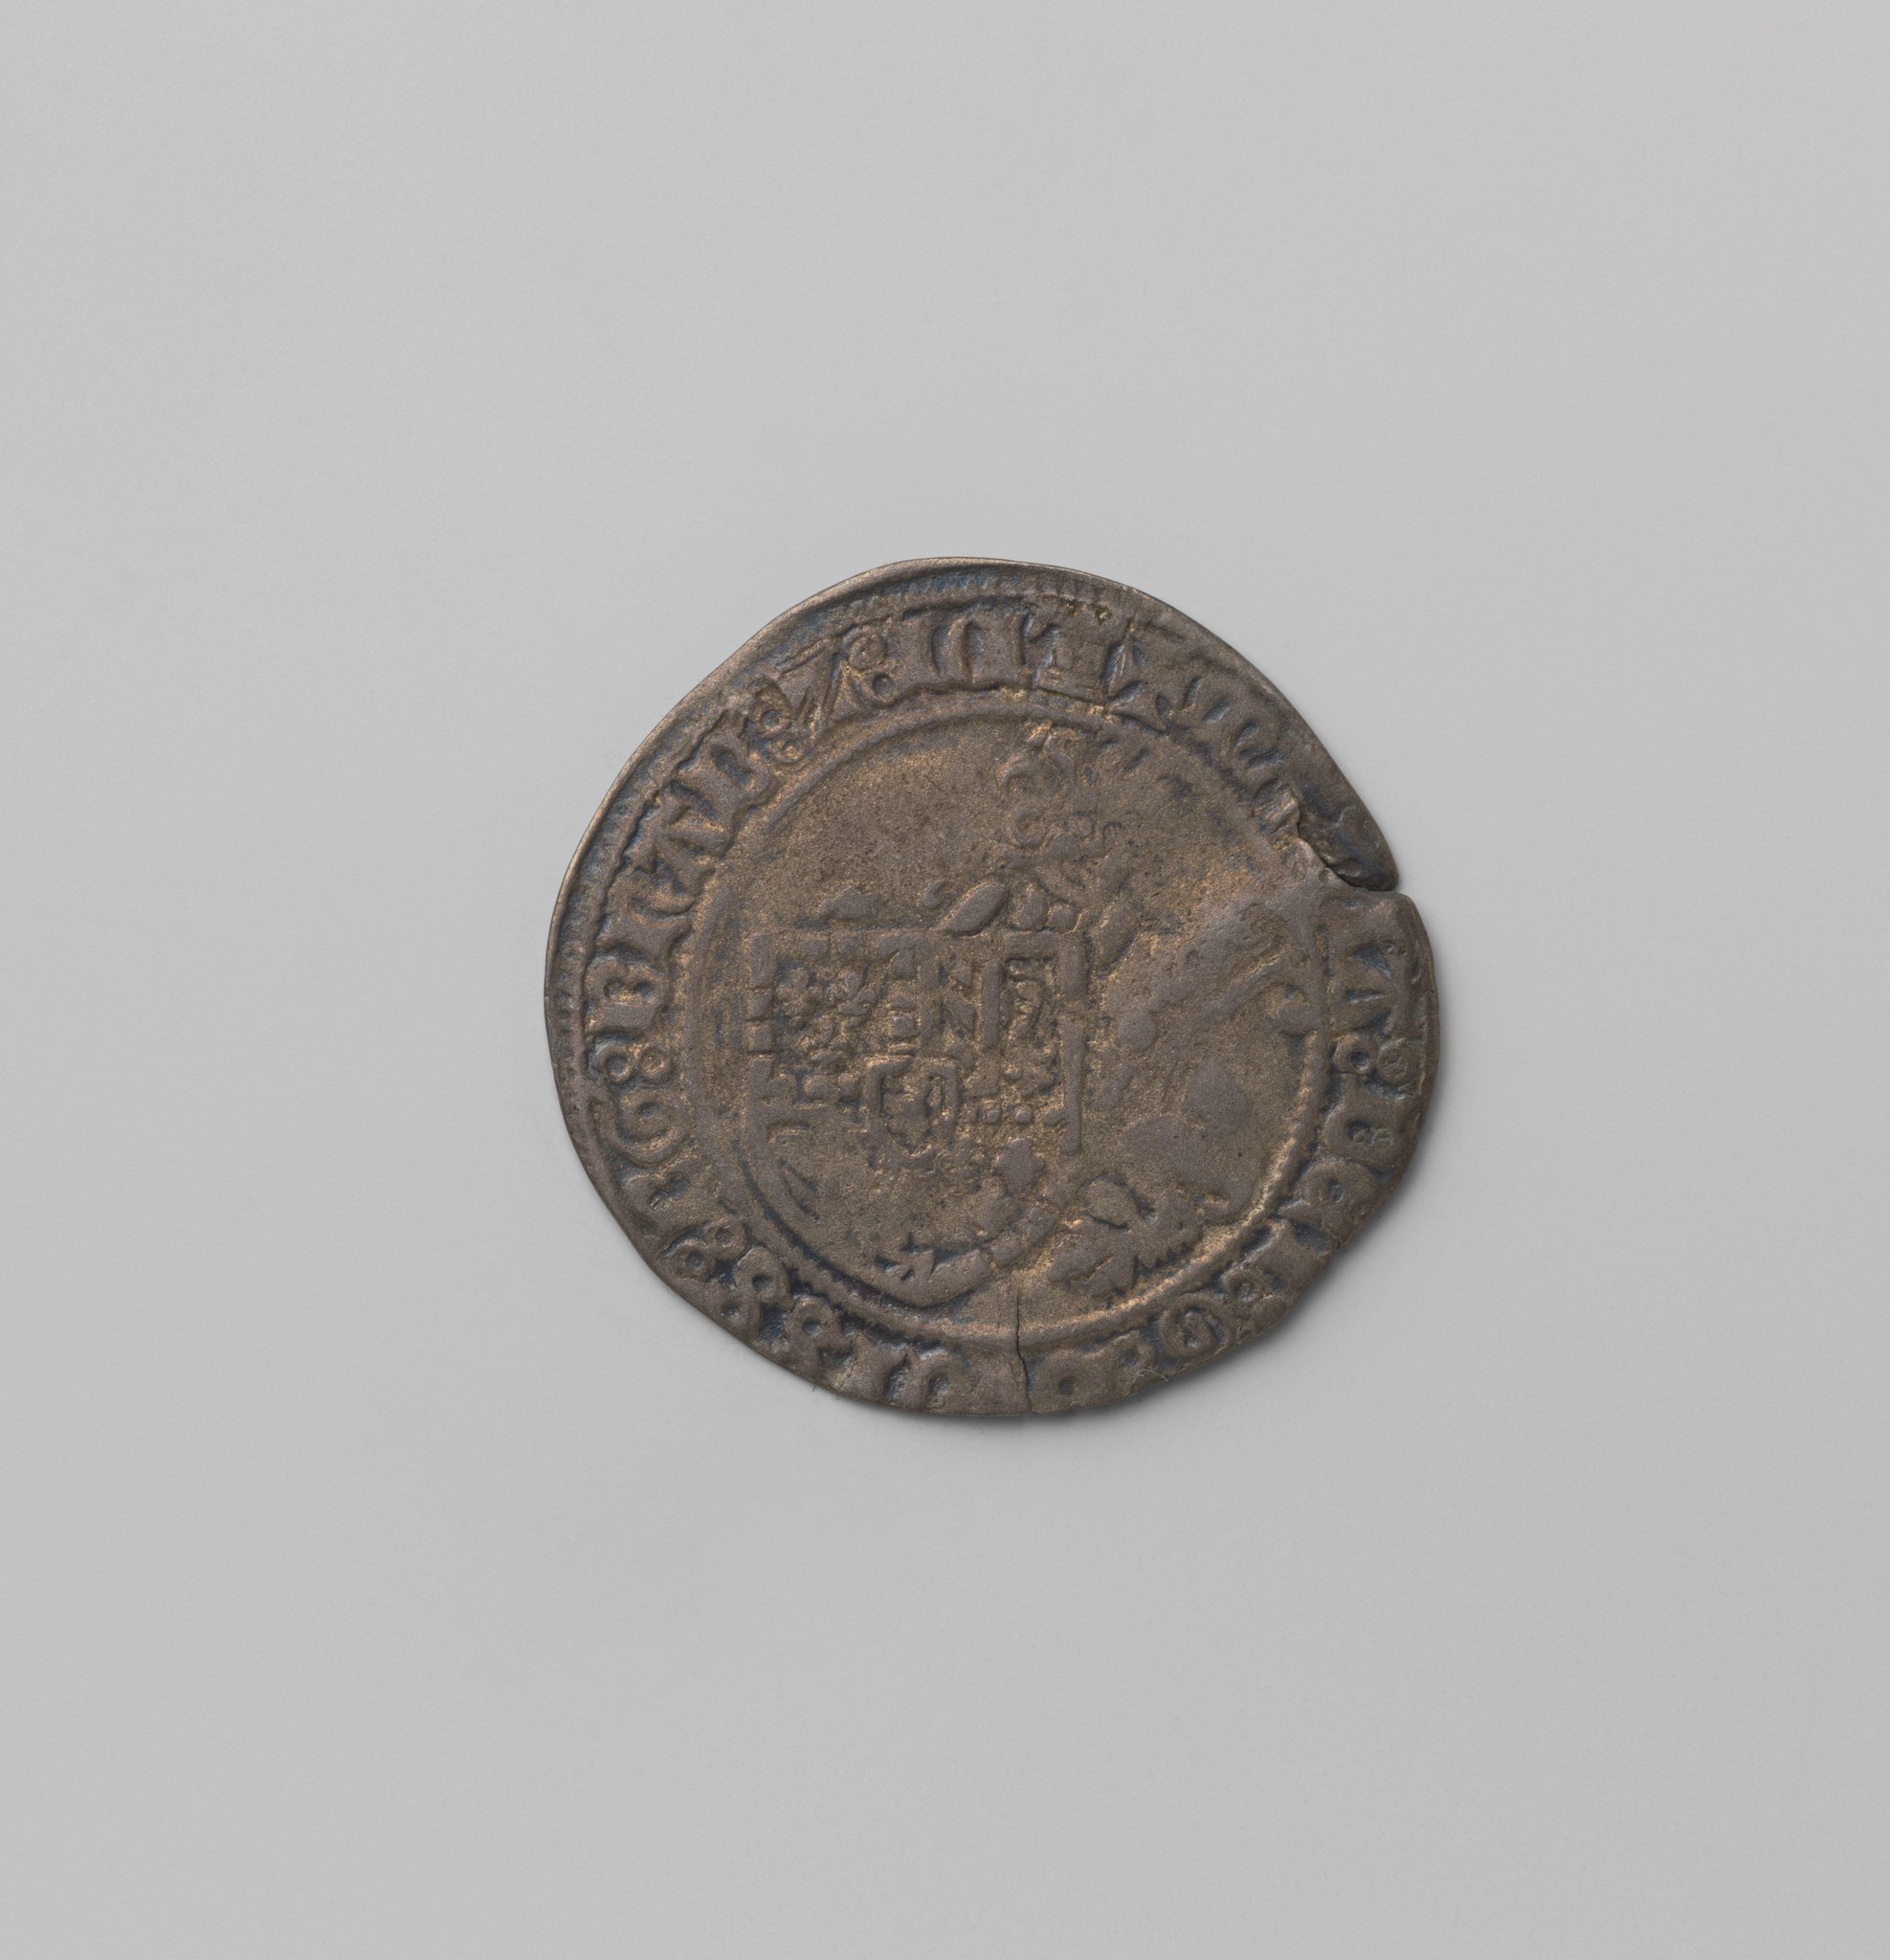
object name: vuurijzer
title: Brabant, Maria van Bourgondië, vuurijzer, 1478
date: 1478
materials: silver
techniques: striking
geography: antwerp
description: Zilveren munt. Voorzijde: zittende leeuw naar links met voor zich wapenschild. Daarboven vuurijzer. Toren aan het eind van het omschrift. Keerzijde: kort gebloemd kruis. Jaartal in omschrift.